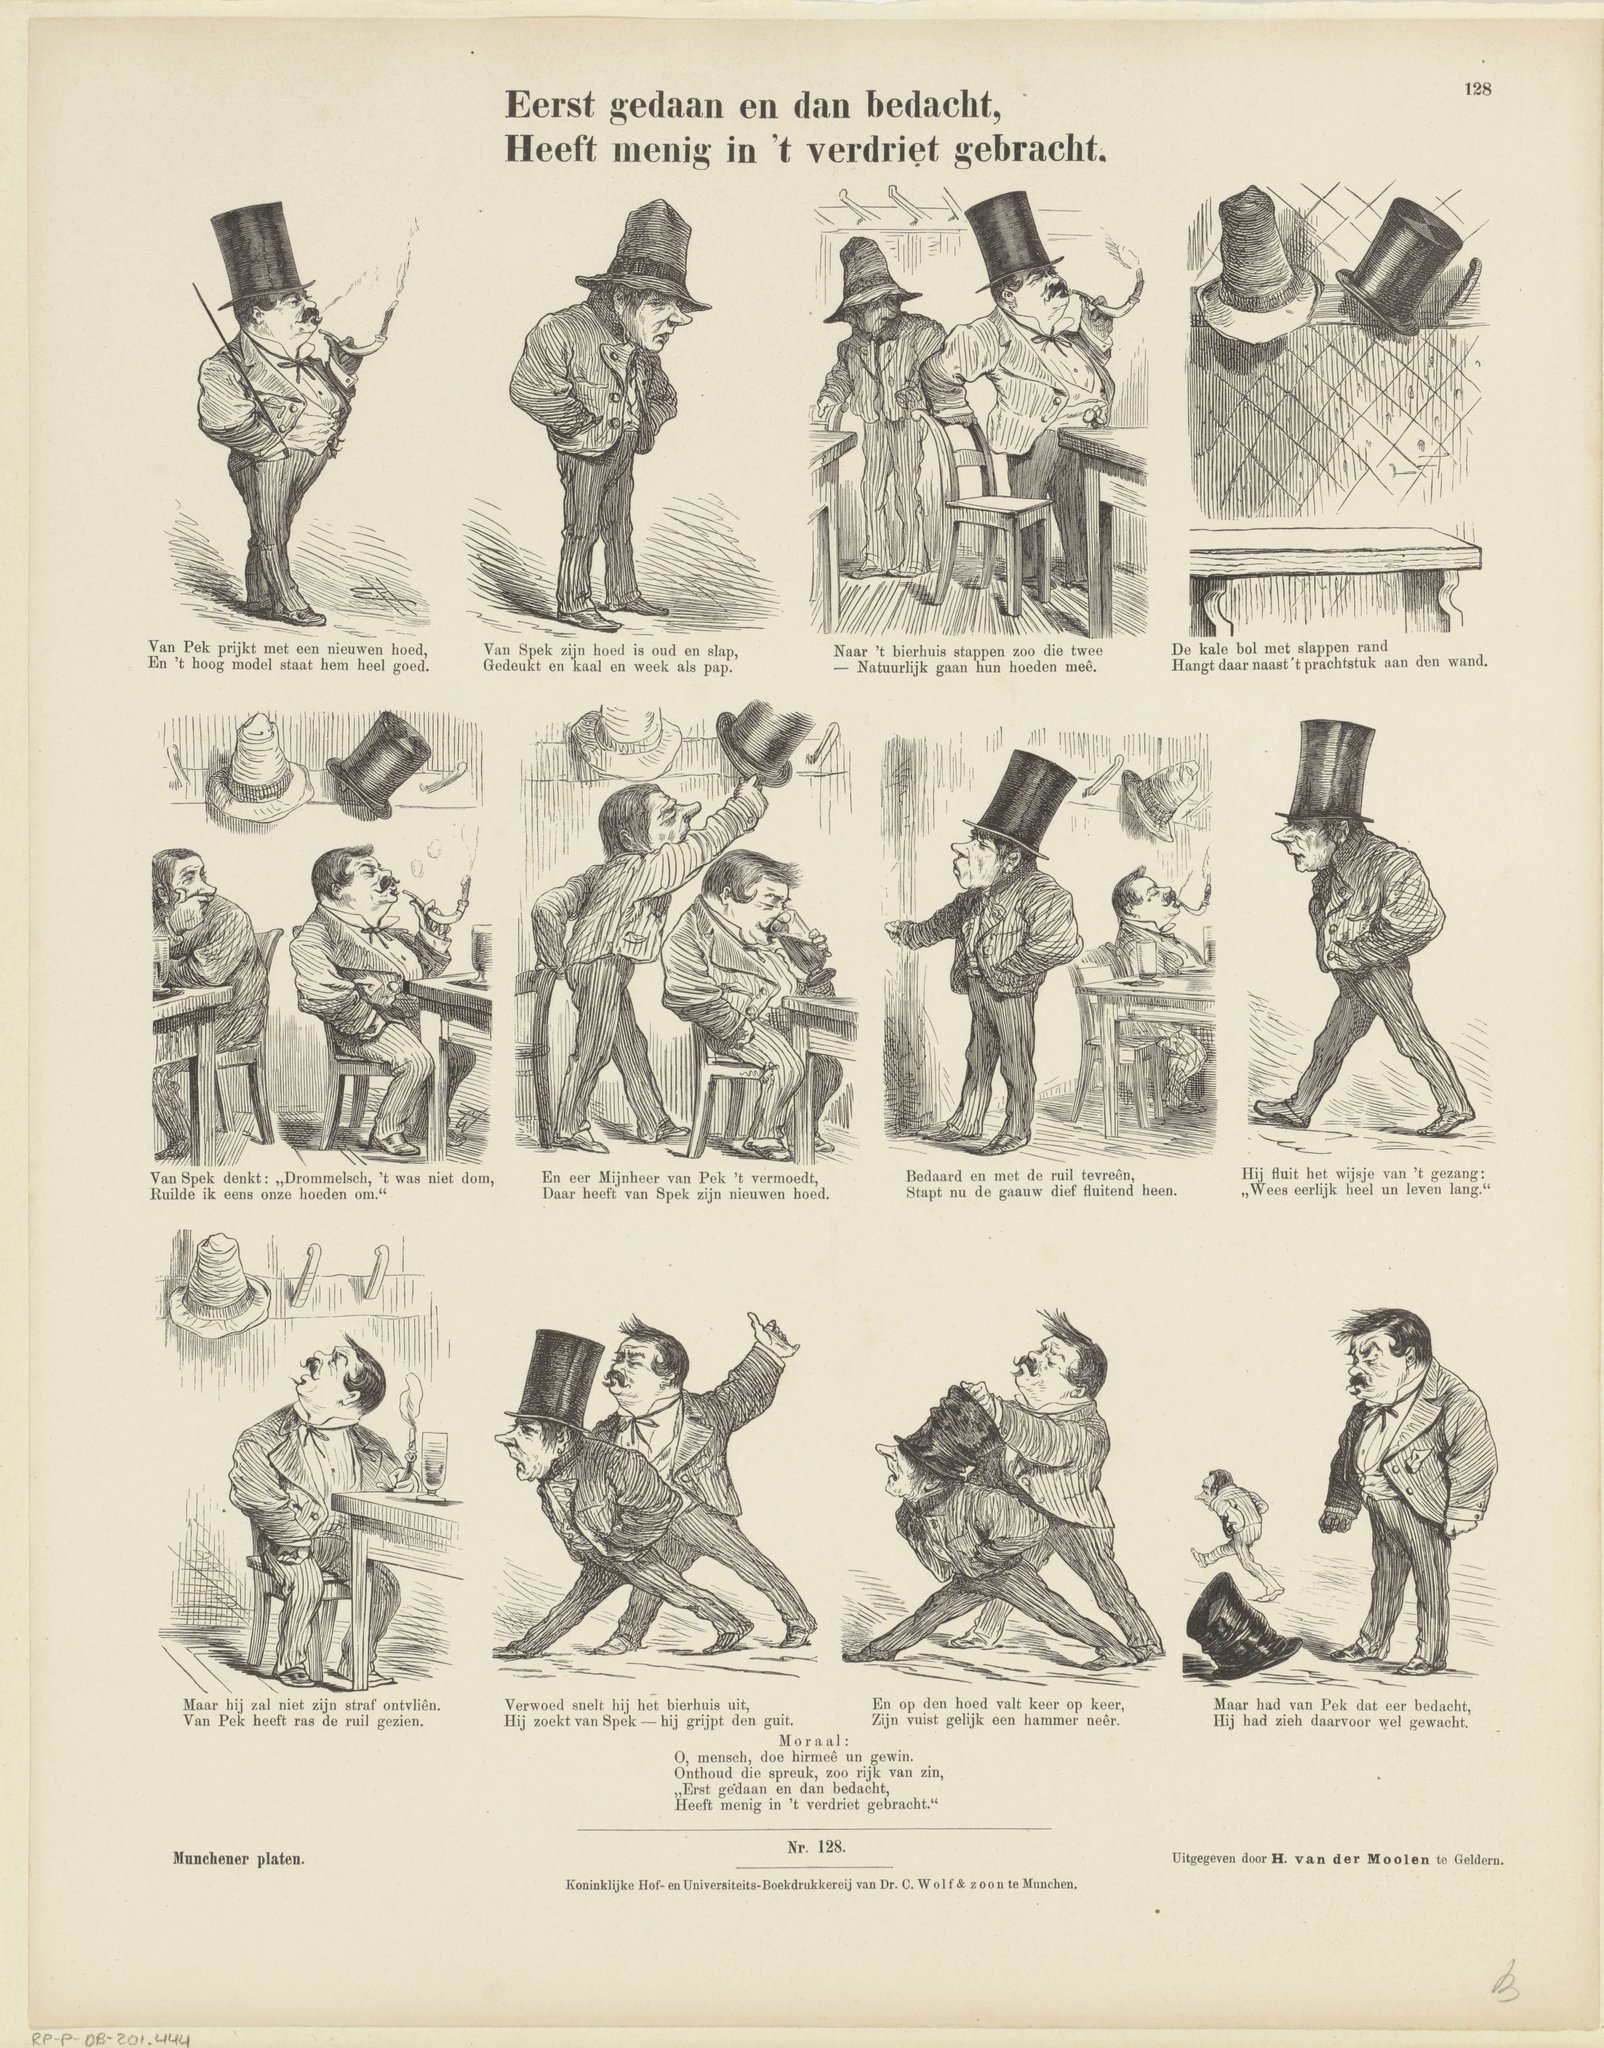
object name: print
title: Eerst gedaan en dan bedacht, / Heeft menig in 't verdriet gebracht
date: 1843-1920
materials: paper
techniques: letterpress printing, engraving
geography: geldern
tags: inn, coffee-house, public house, etc., robber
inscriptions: collector's mark: Lugt 2760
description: Blad met 12 voorstellingen over meneer Van Spek die de hoed steelt van meneer Van Pek. Onder elke afbeelding een tweeregelig vers. In de ondermarge een vierregelig vers. Genummerd midden onder: Nro. 128. Genummerd rechtsboven: 128.